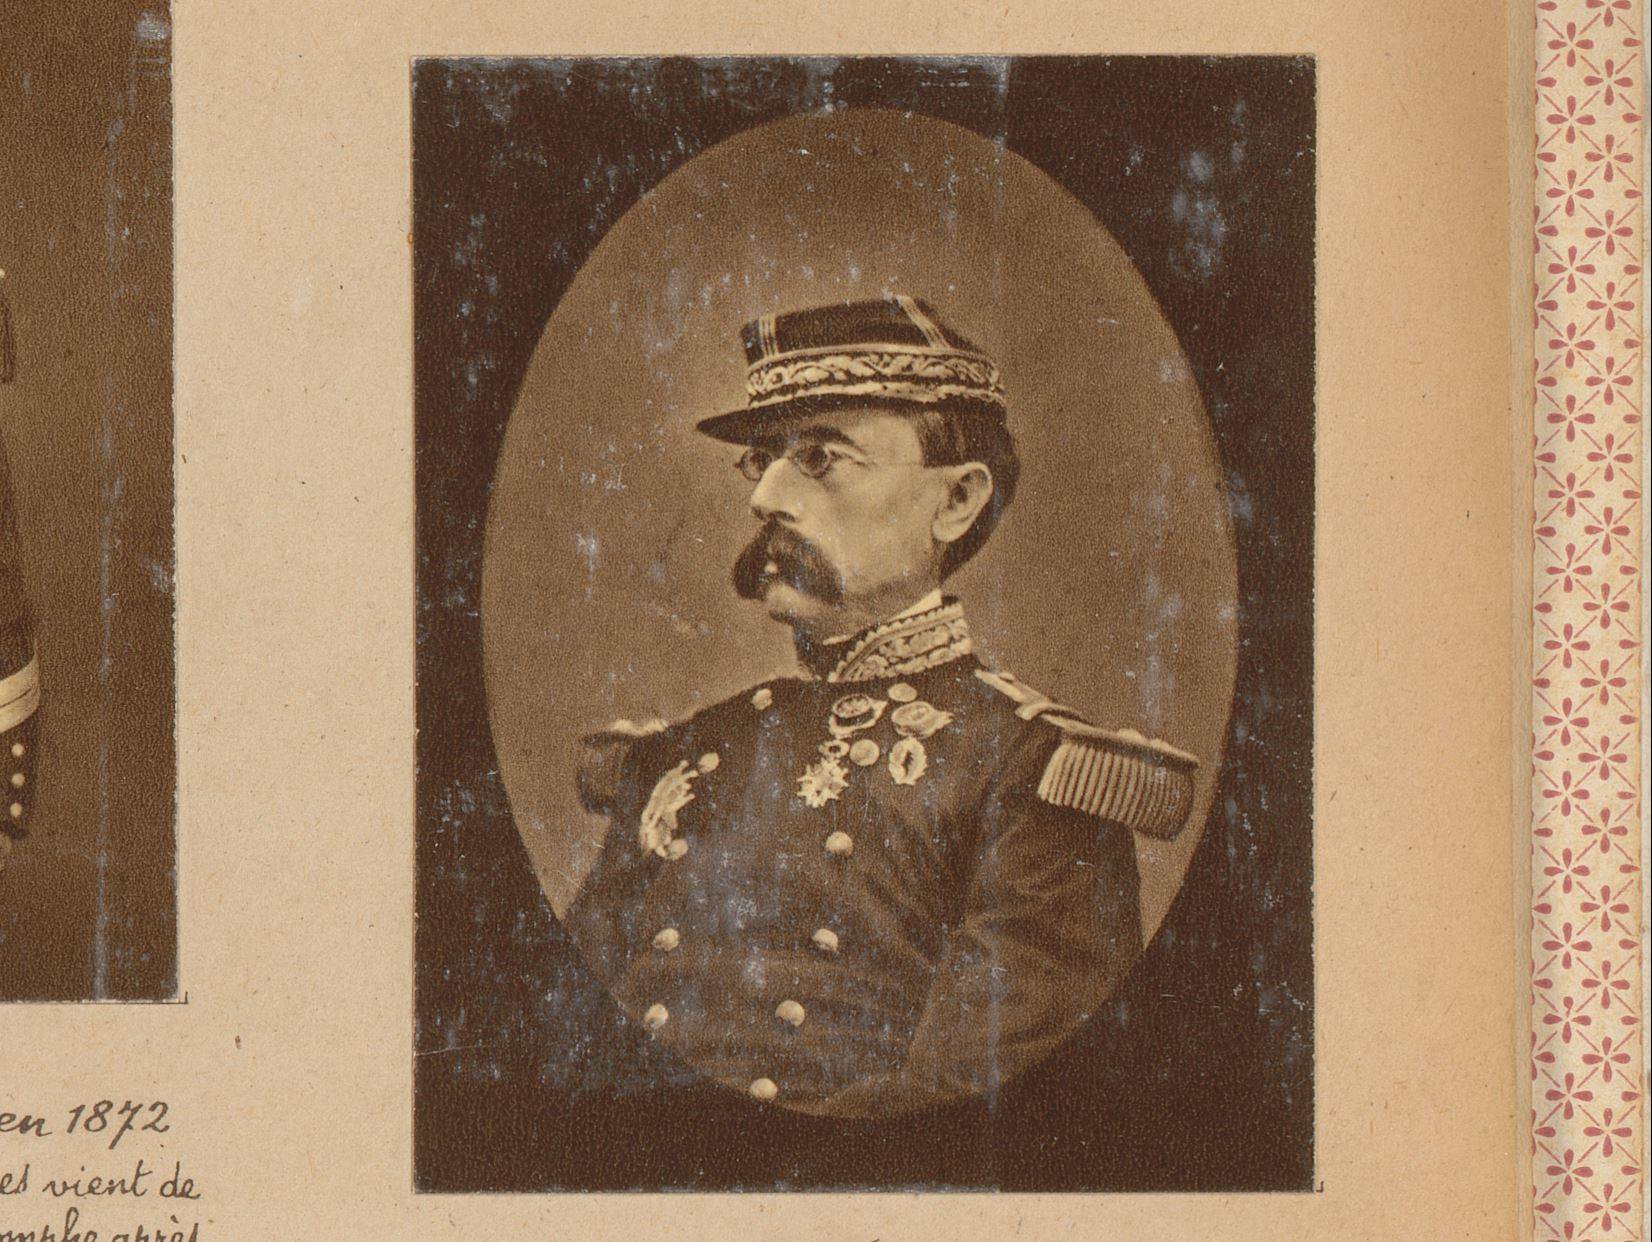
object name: photograph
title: Général Faidherbe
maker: Anonymous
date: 1870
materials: paper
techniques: rotogravure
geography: france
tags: commander-in-chief, general, marshal, historical persons, france